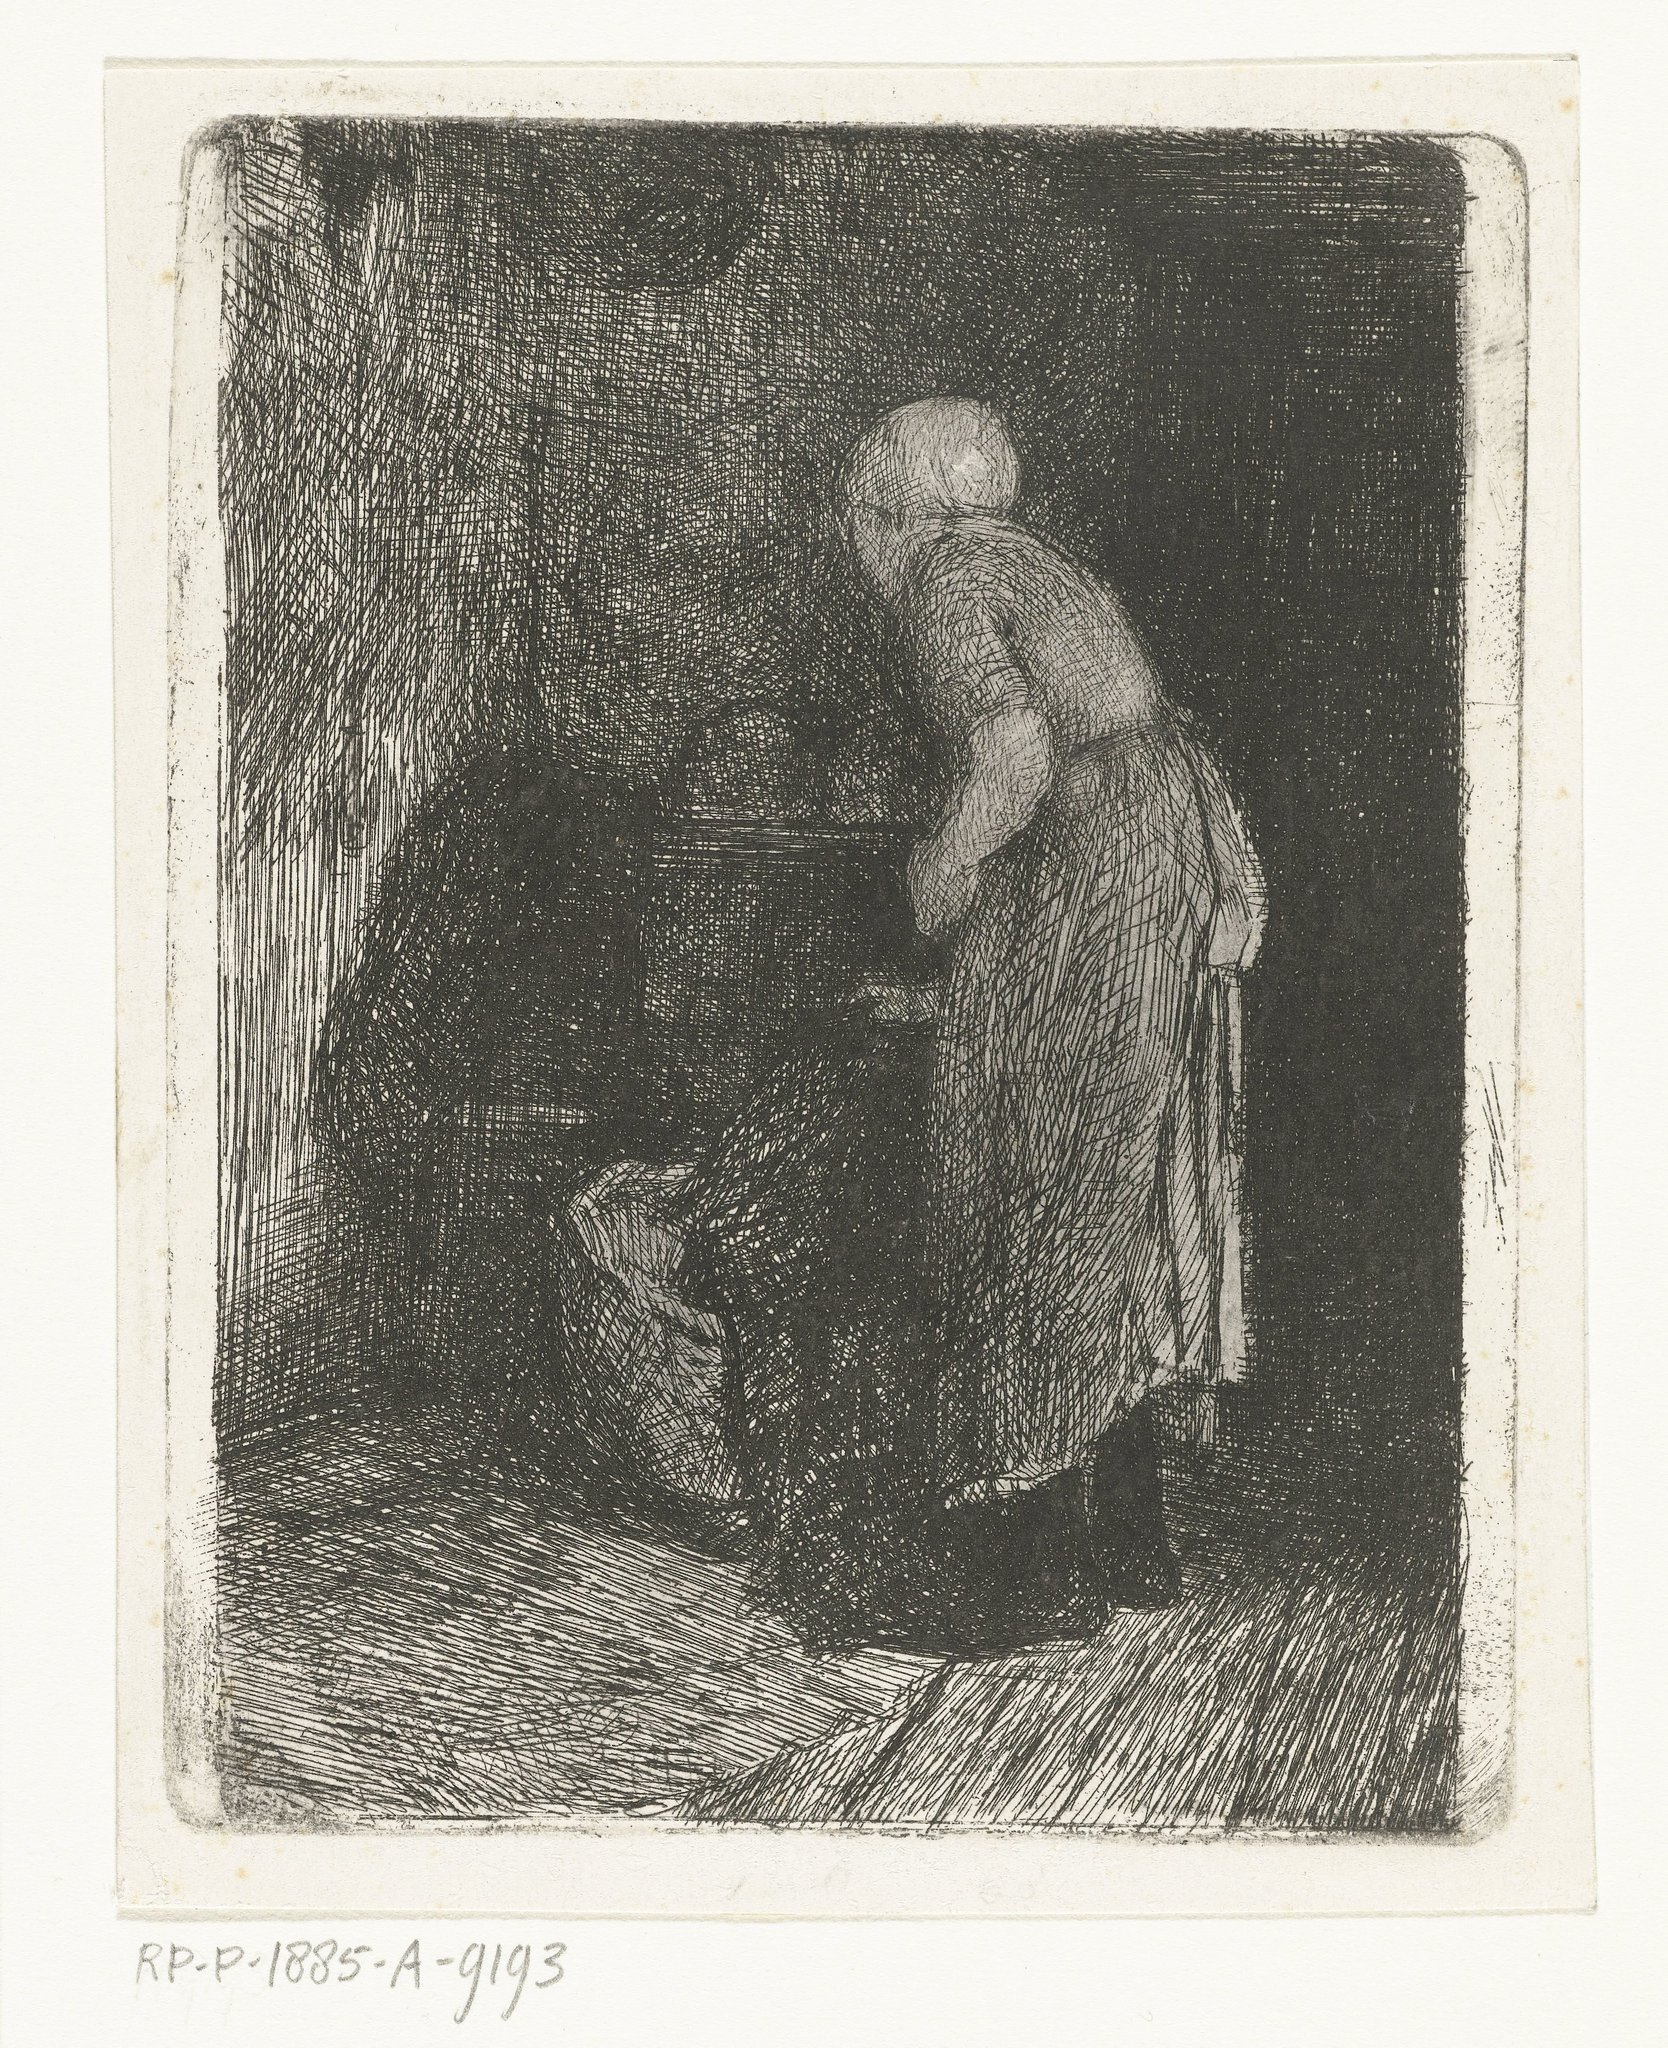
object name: print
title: Vrouw kijkt in een wieg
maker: bernardus johannes blommers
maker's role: draughtsman, print maker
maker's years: 1845-1914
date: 1855-1885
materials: paper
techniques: drypoint, etching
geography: netherlands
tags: cradle, crib, mother and baby or young child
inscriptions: collector's mark: Lugt 2228